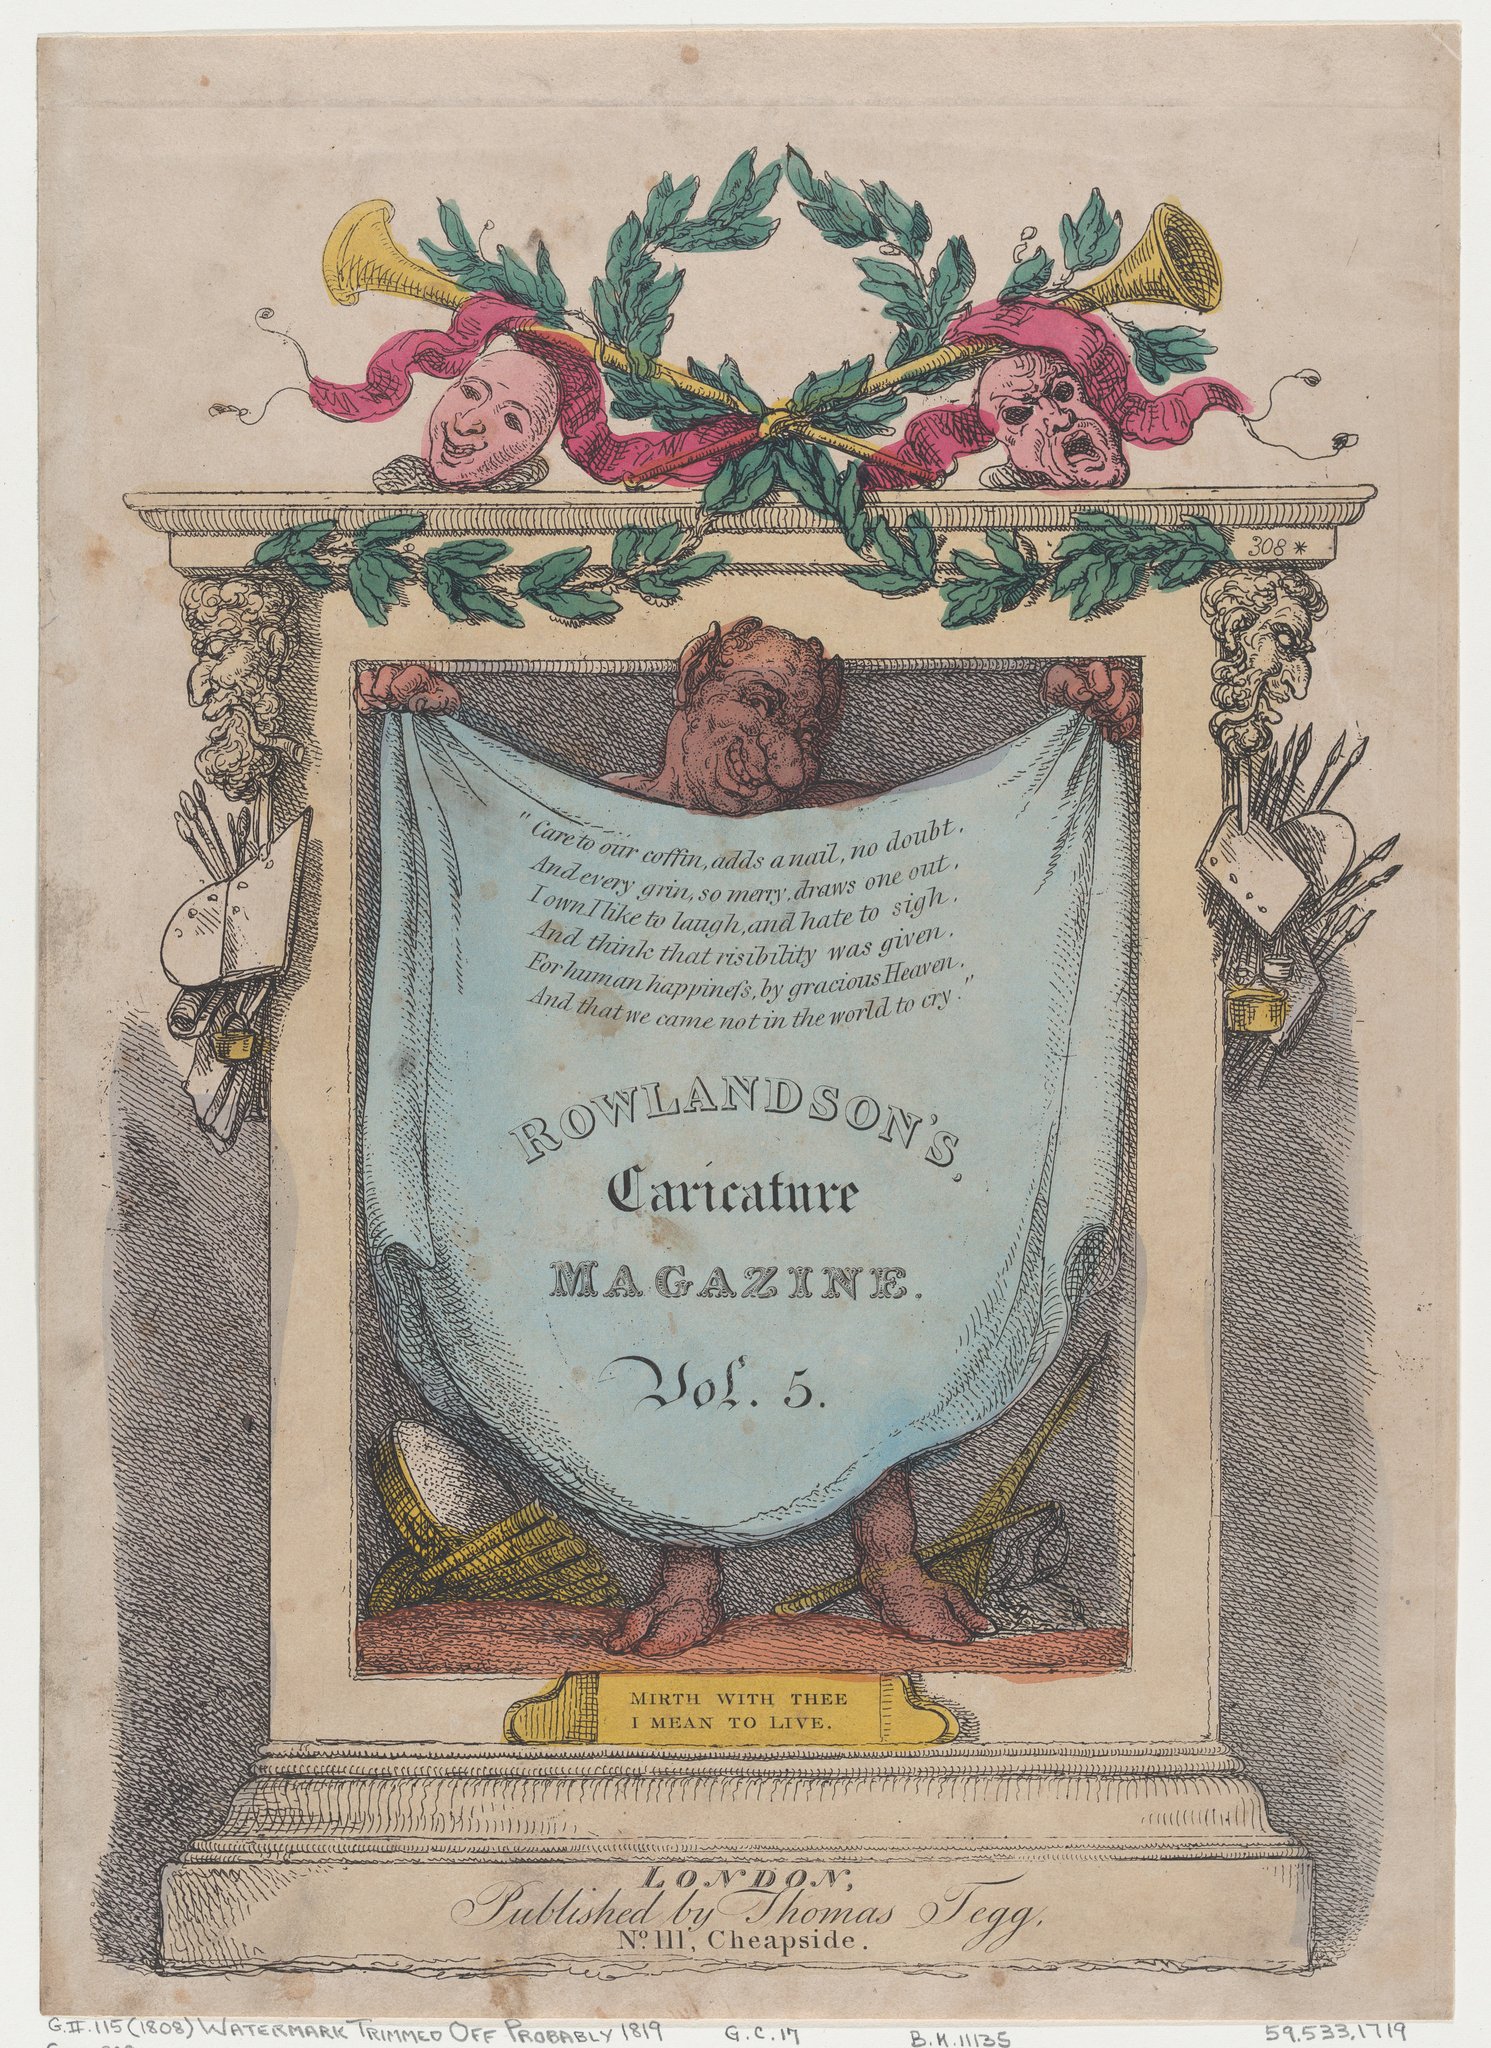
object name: print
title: Title Page, Rowlandson's Caricature Magazine, Vol. 5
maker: thomas rowlandson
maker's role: artist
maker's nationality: british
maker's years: 1757-1827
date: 1808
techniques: etching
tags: satyrs,caricature